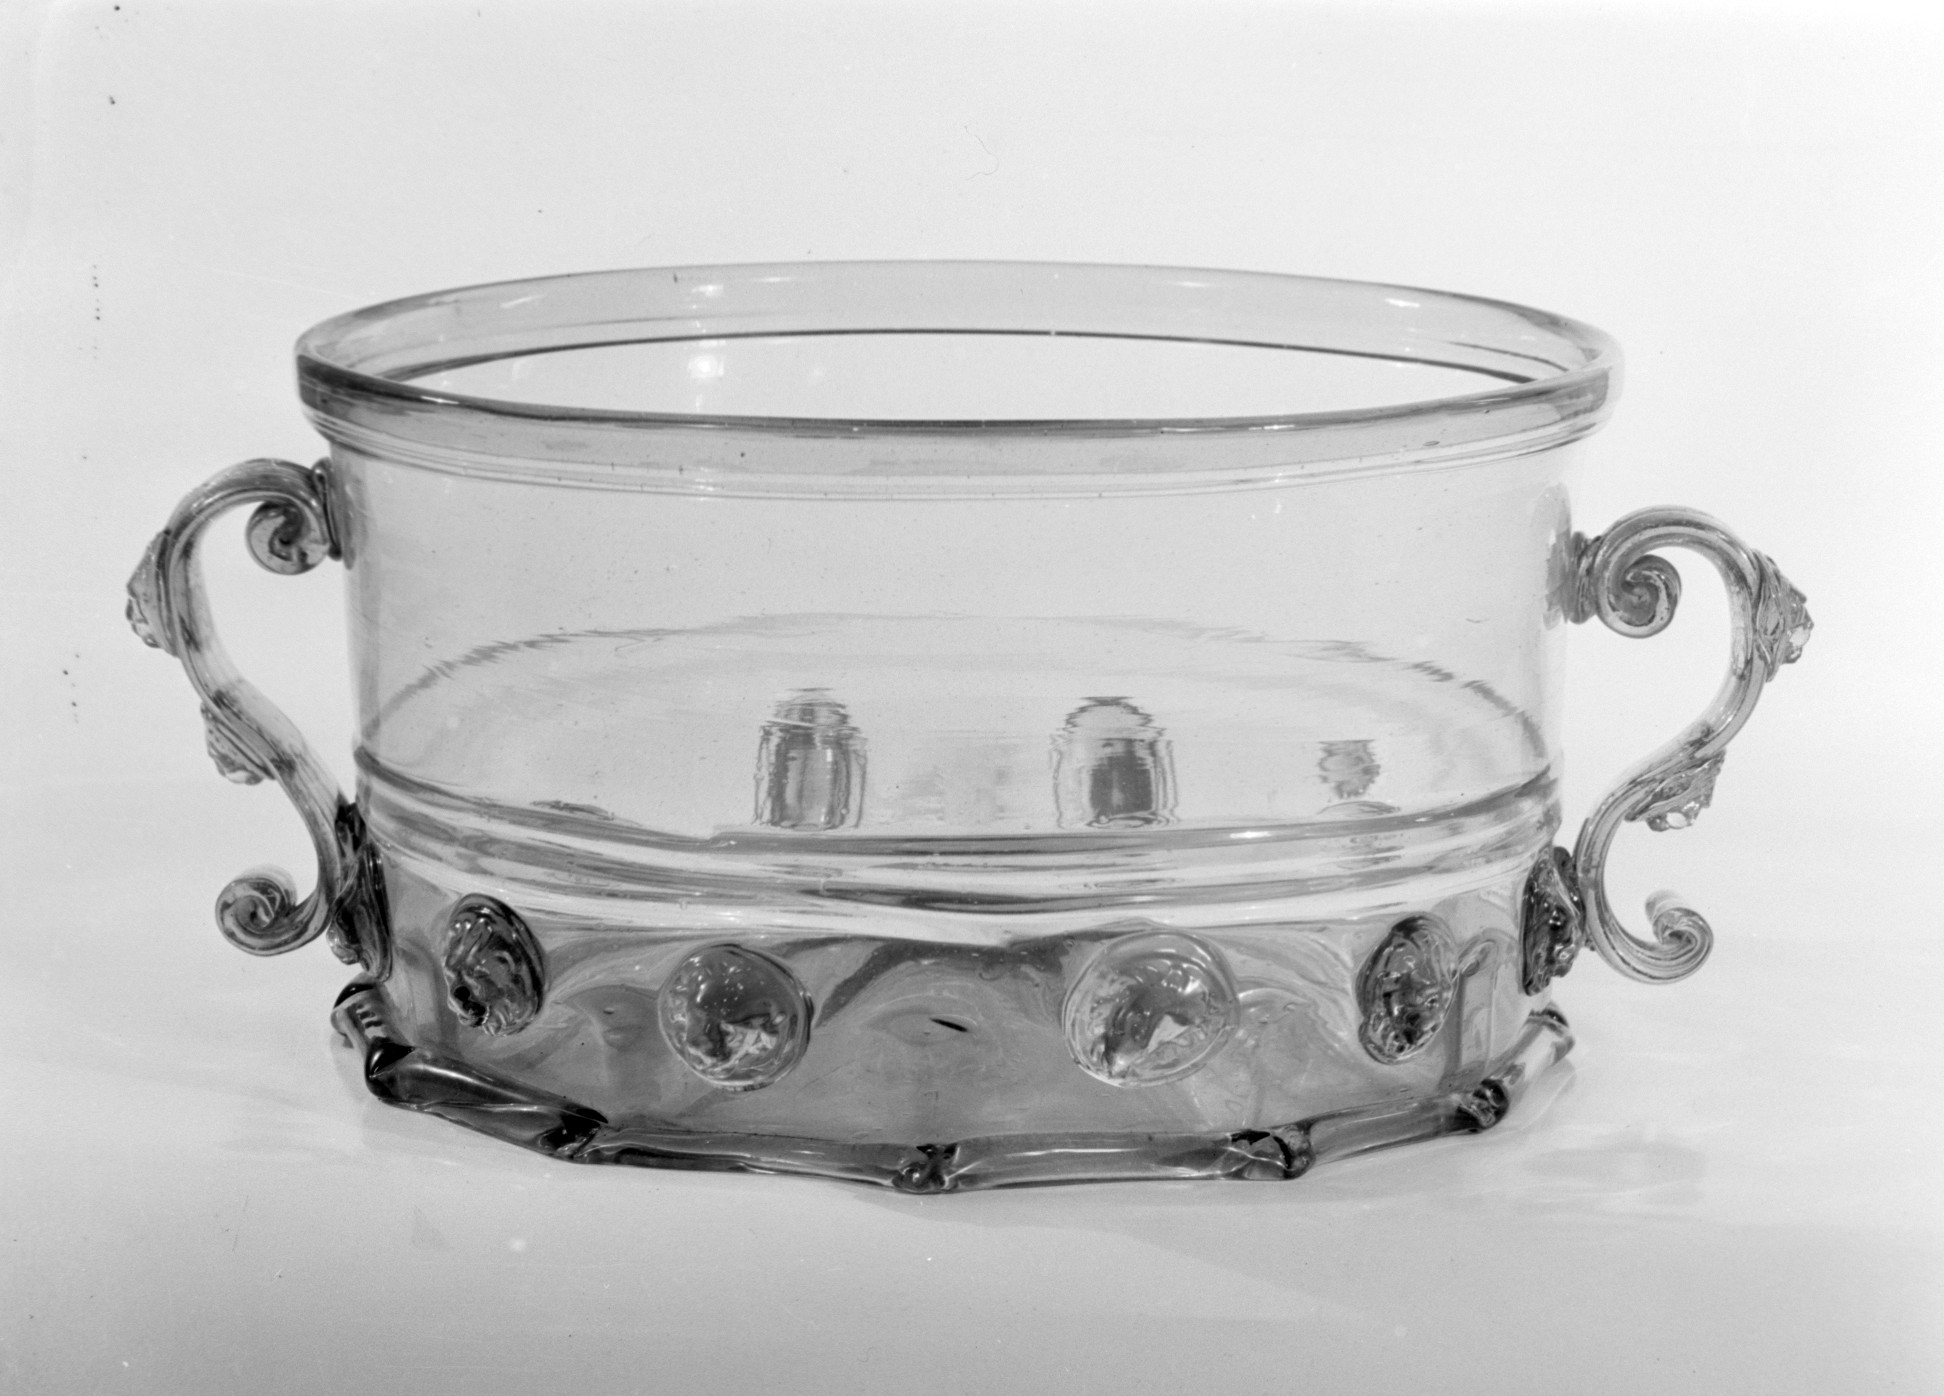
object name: bowl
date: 1501-1600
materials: glass